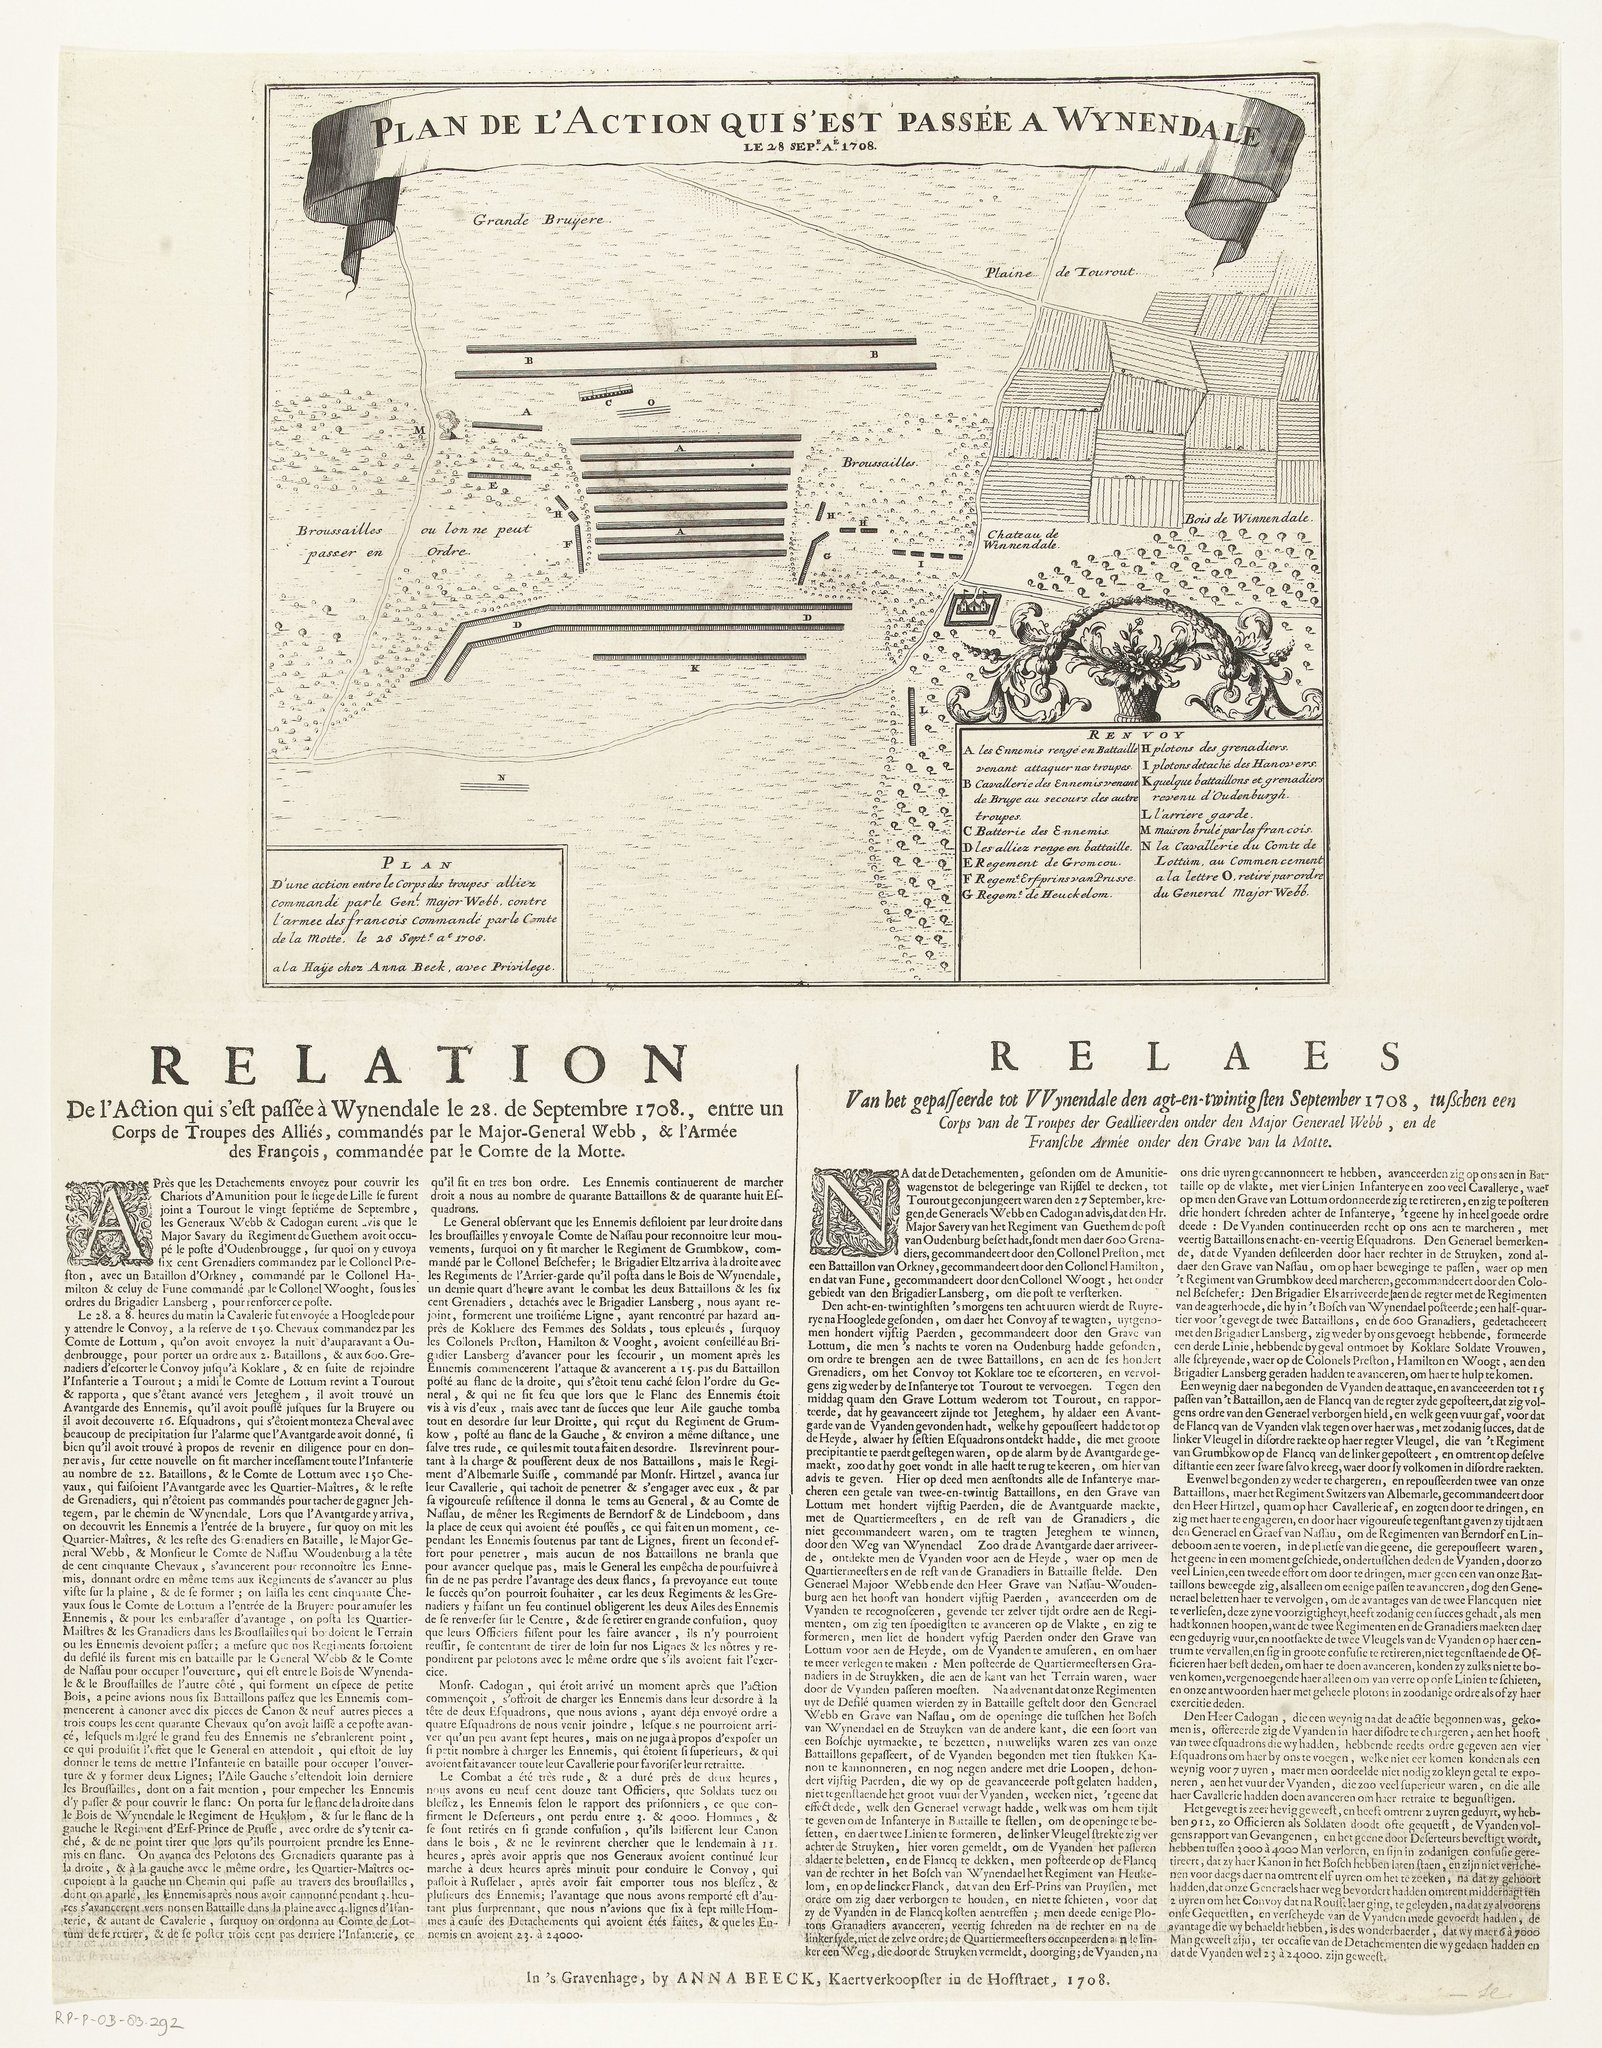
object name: print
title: Plan de l'Action qui s'est passée a Wynendale de 28 sep.e aé. 1708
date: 1708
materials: paper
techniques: etching, letterpress printing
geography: northern netherlands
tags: maps of separate countries or regions, battle (+ land forces)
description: Plattegrond van de slag op 28 september 1708 bij Wijnendale in West-Vlaanderen tussen de geallieerde troepen onder generaal-majoor Webb die een konvooi begeleidden en Franse troepen onder Graaf de la Mott. Gedrukt op het blad onder de plaat een relaas van het gevecht in 2 kolommen in het Frans en 2 kolommen in het Nederlands.